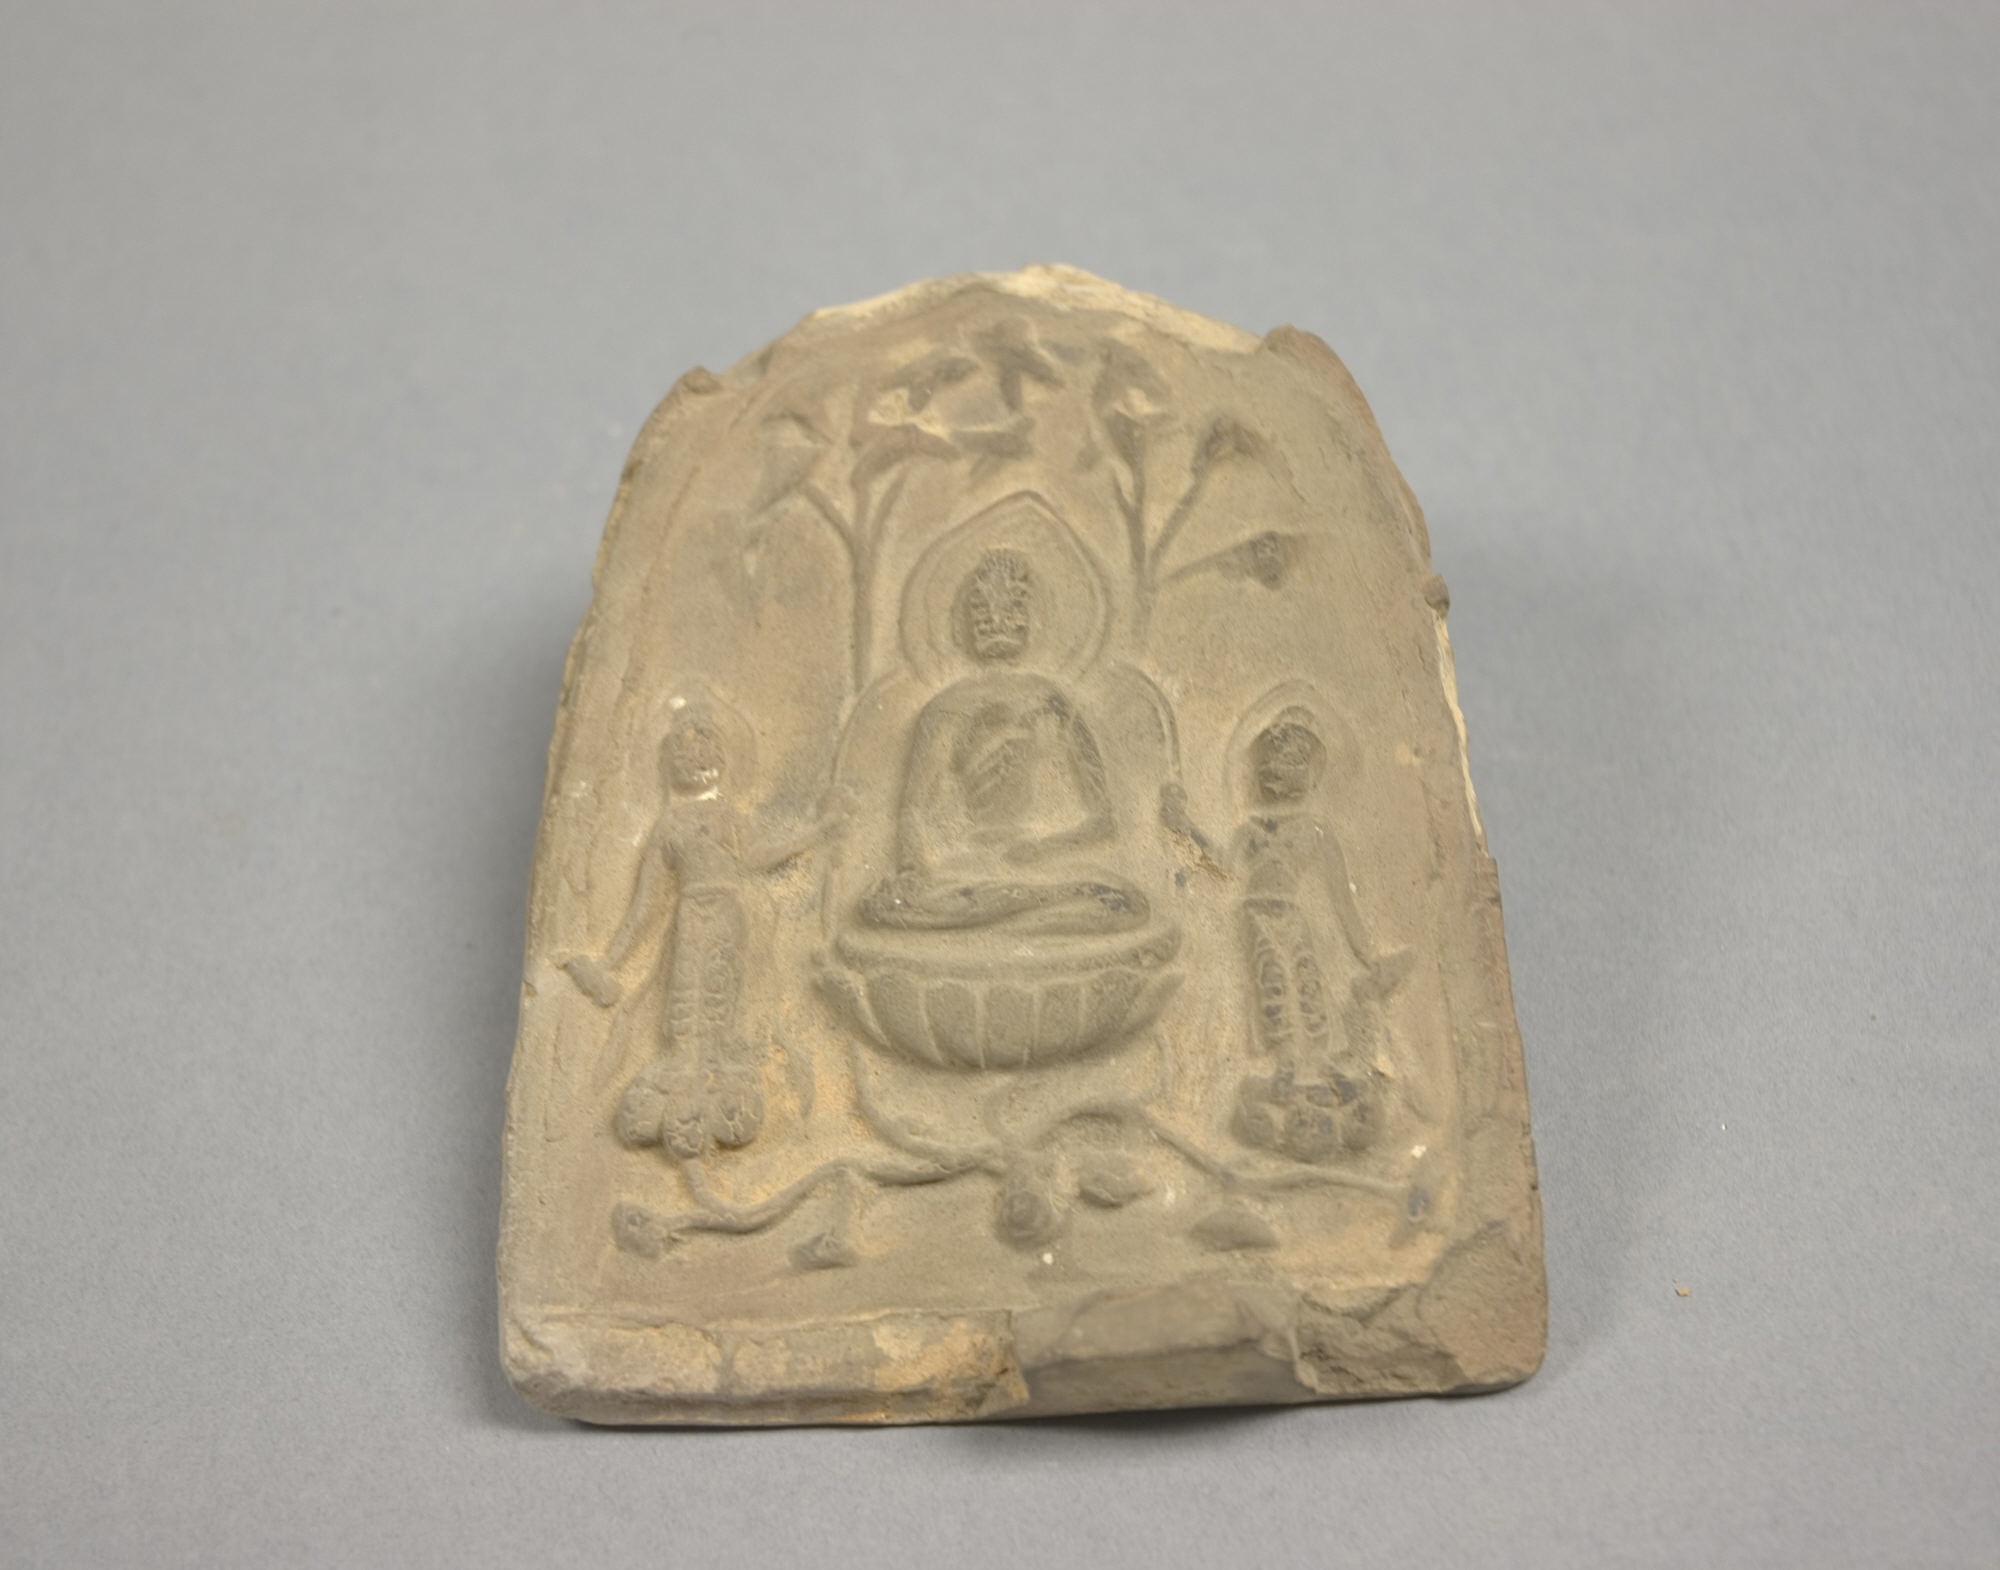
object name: votive tablet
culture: chinese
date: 618-907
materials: terracotta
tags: buddhism,bodhisattvas,buddha